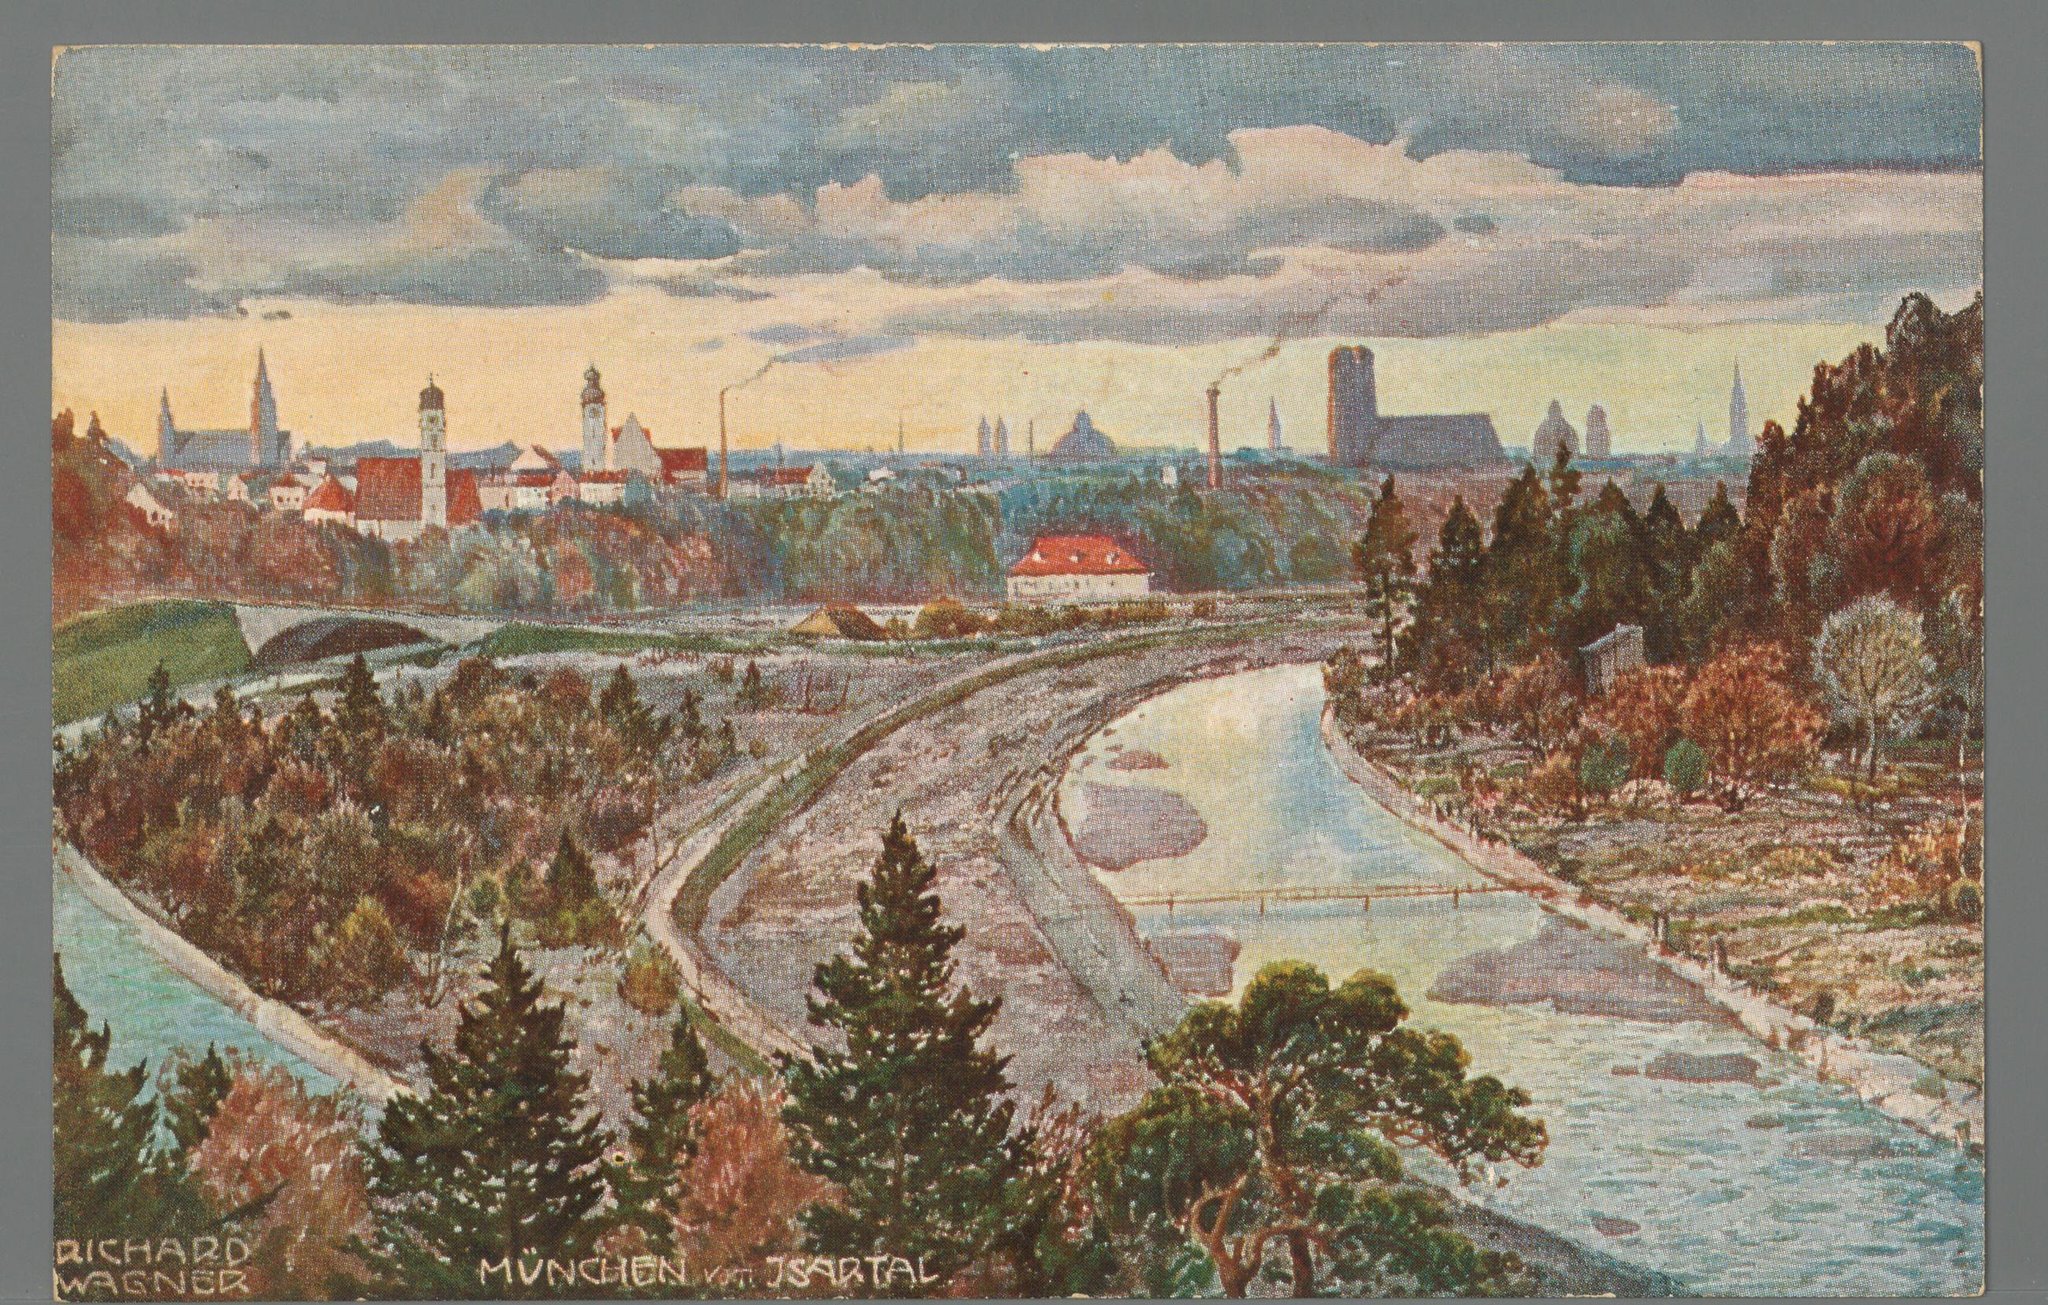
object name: reproduction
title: Aquarell-Serie München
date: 1905-1930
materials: cardboard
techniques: color autotype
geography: munich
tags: city-view, and landscape with man-made constructions, church (exterior), canals, waters (in city)